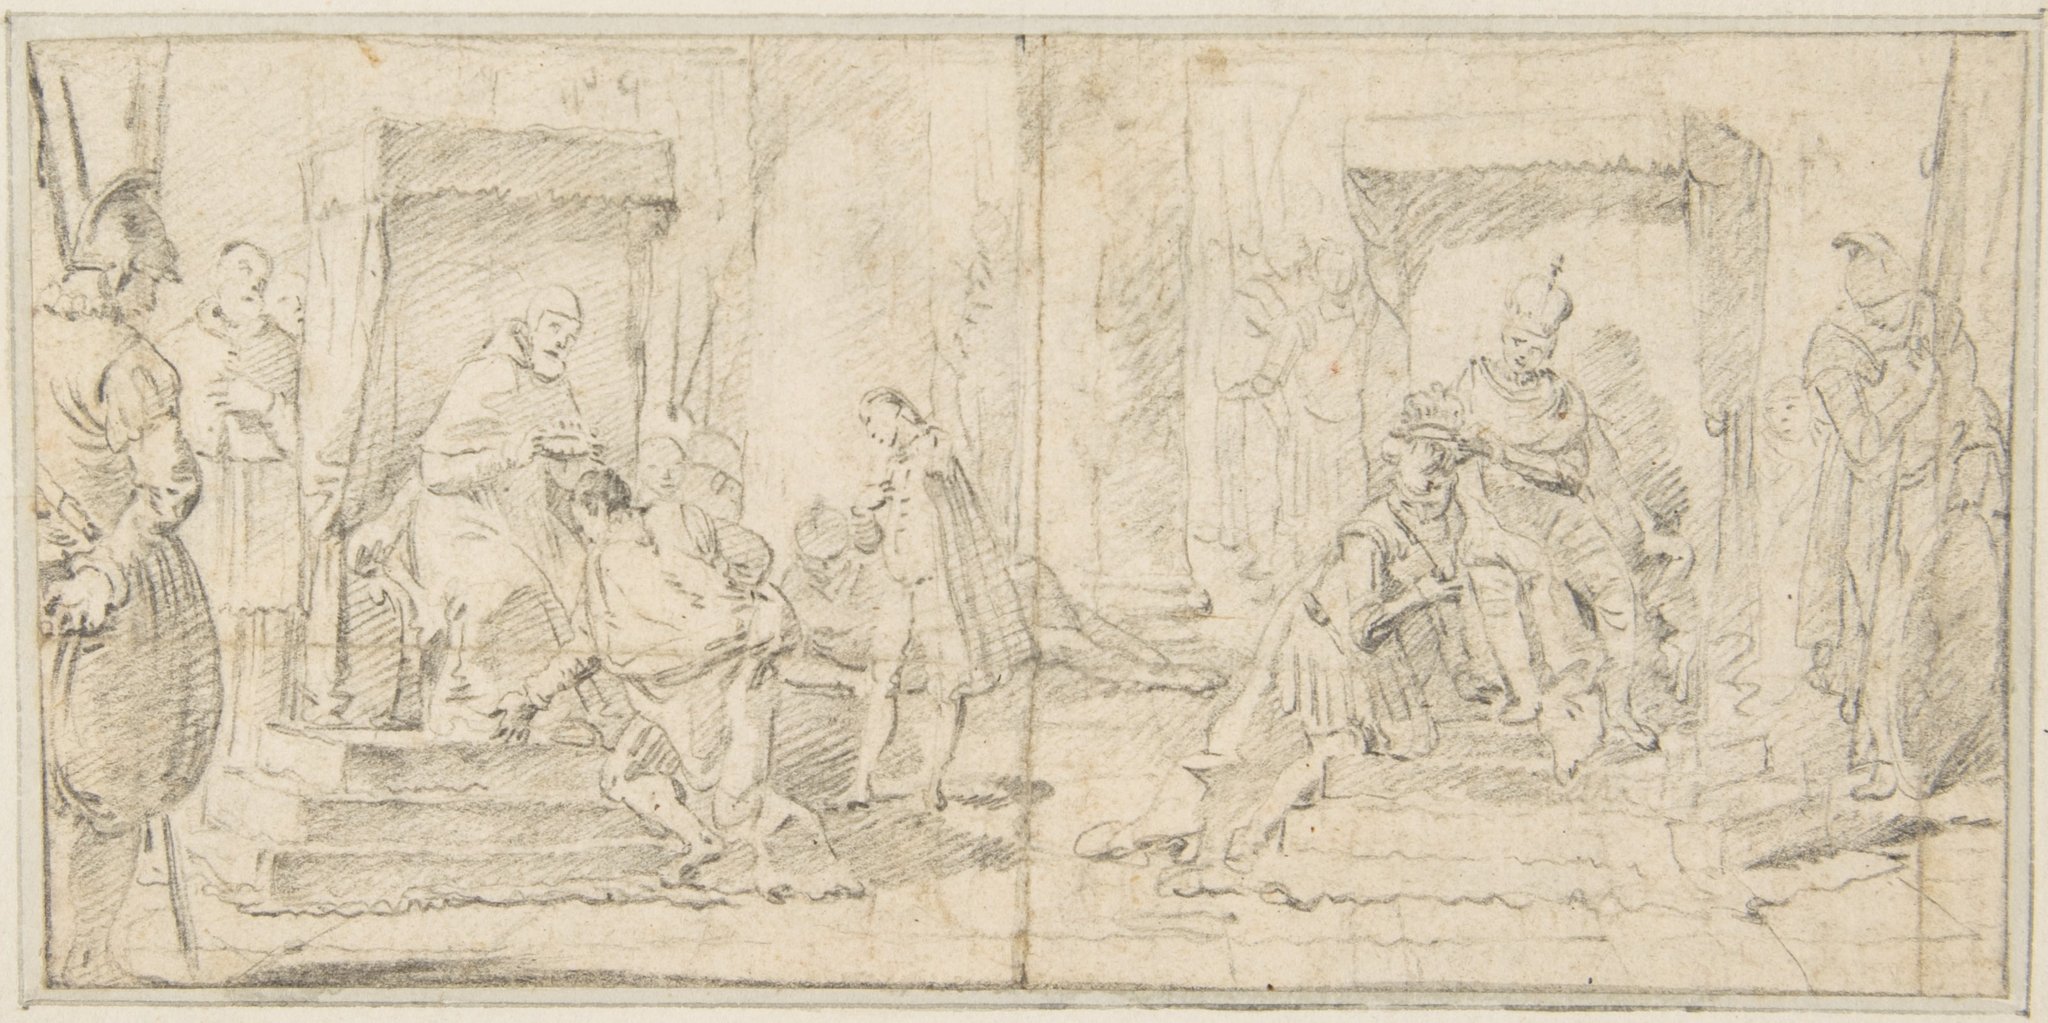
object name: drawing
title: Illustration for a Book: Two Scenes of Coronation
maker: giovanni battista tiepolo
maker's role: artist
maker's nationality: italian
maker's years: 1696-1770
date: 1696-1770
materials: chalk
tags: kings,men,ceremony